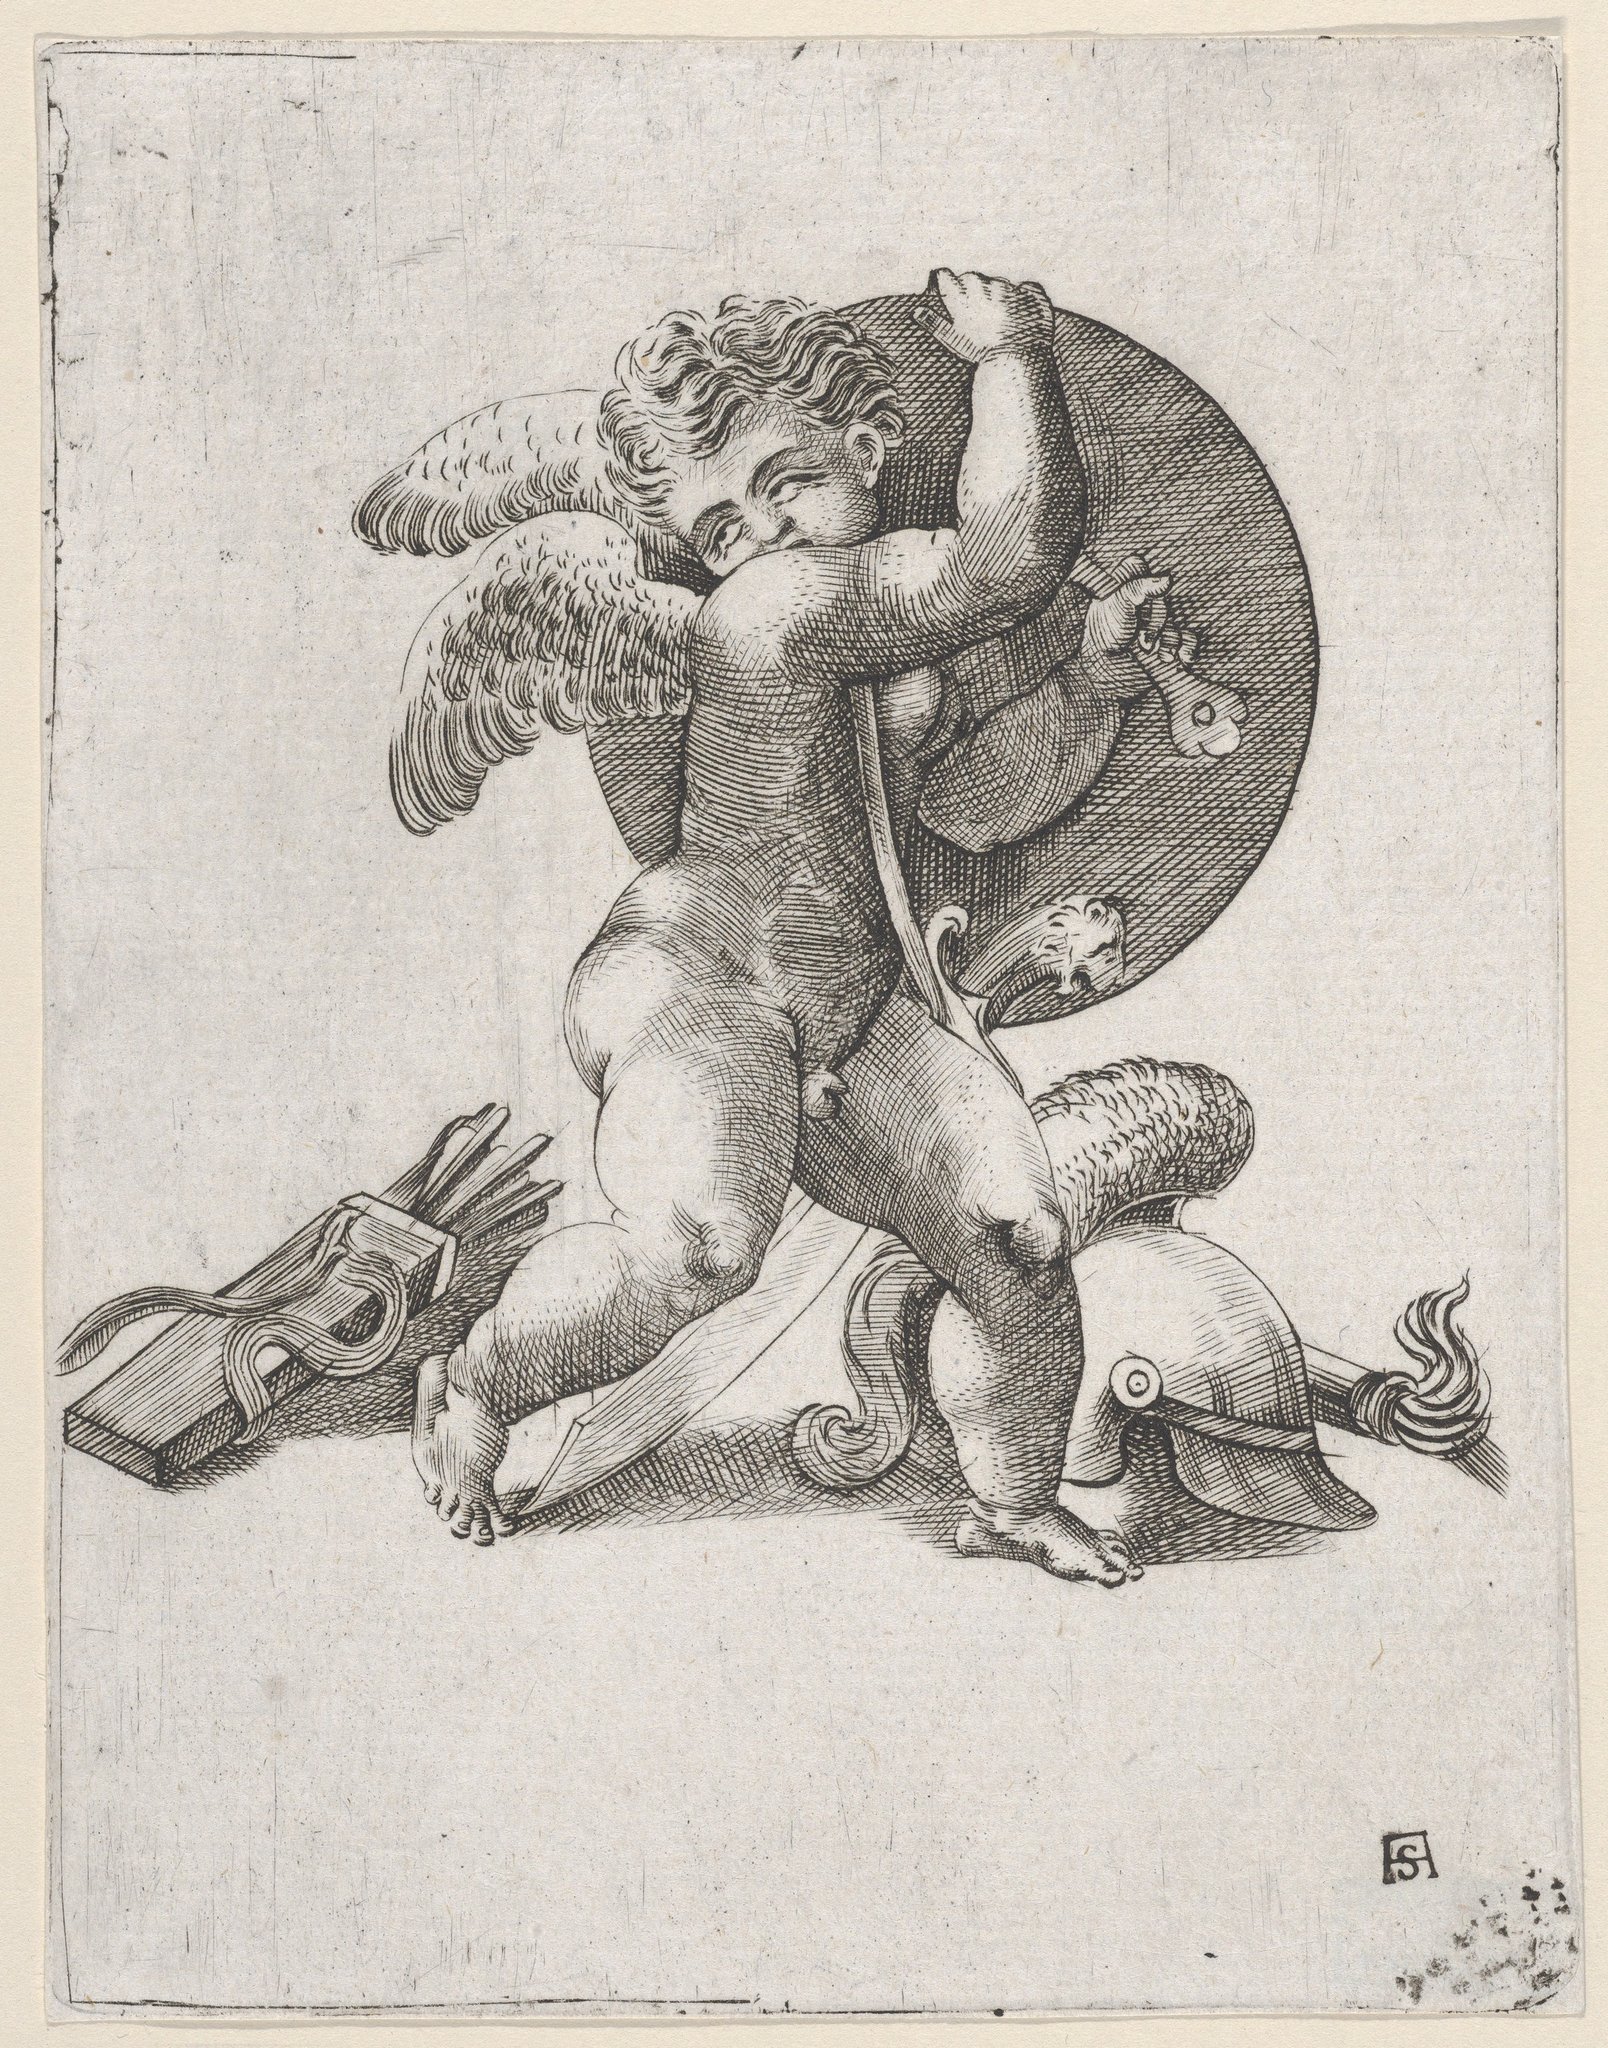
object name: print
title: Cupid with Weapons of Mars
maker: adamo scultori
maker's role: artist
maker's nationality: italian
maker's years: 1530-1587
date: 1547-1562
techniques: engraving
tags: arrows,helmets,shields,cupid